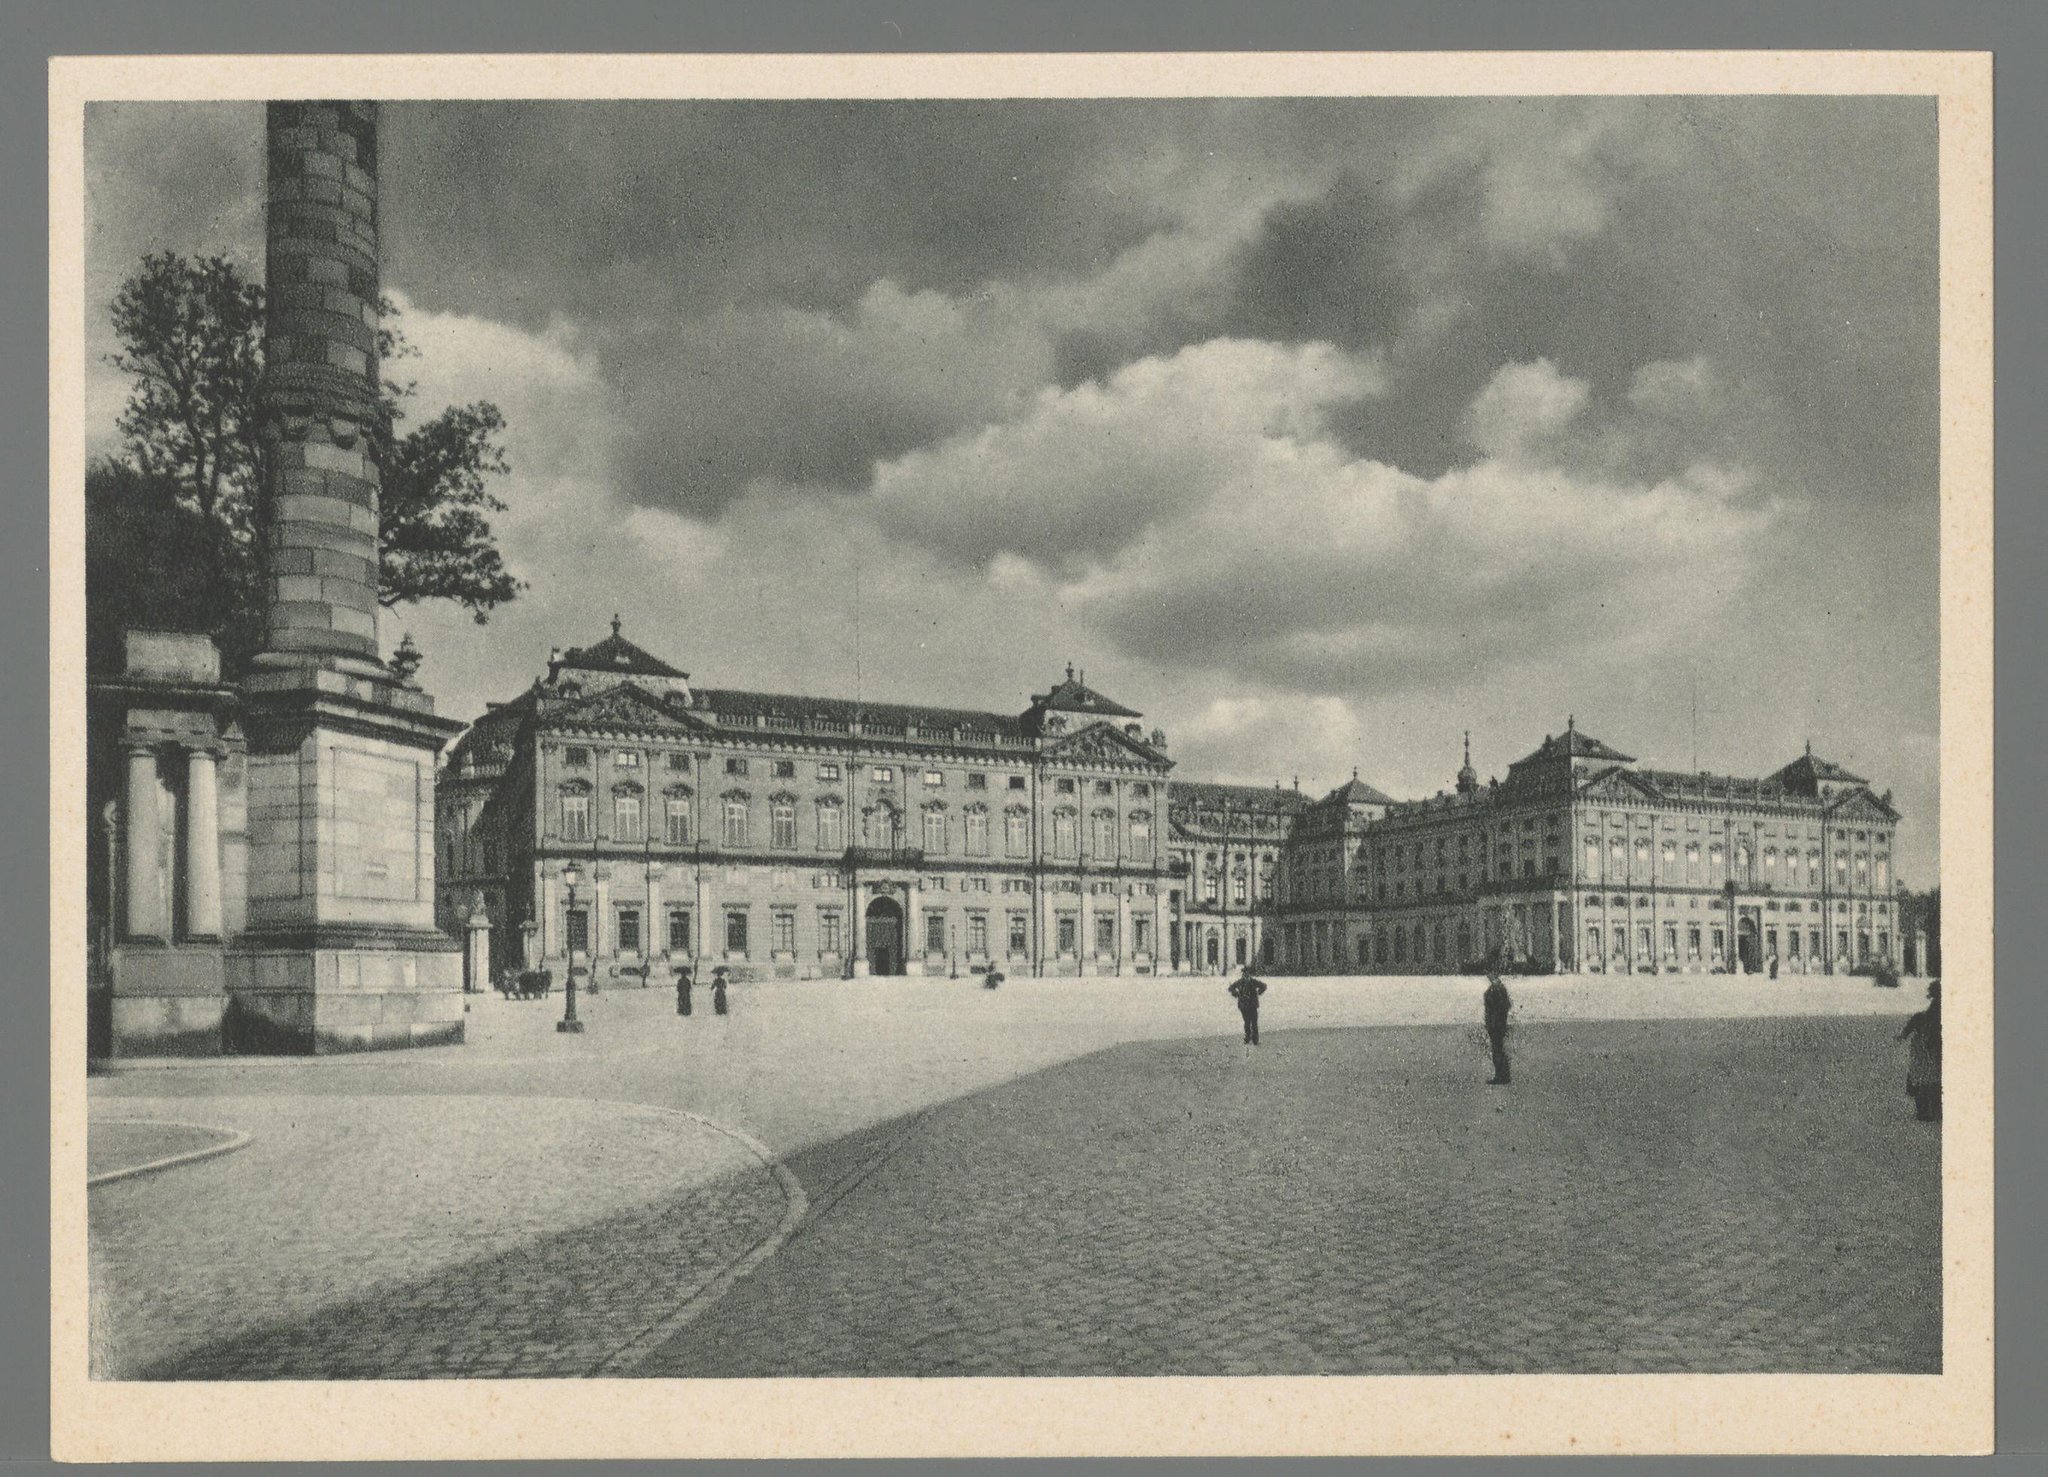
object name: ansichtkaart, prentbriefkaart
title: Residenz Würzburg. Stadtfront der Residenz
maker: Anonymous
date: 1905-1950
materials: cardboard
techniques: rotogravure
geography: würzburg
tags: square, place, circus, etc., palace